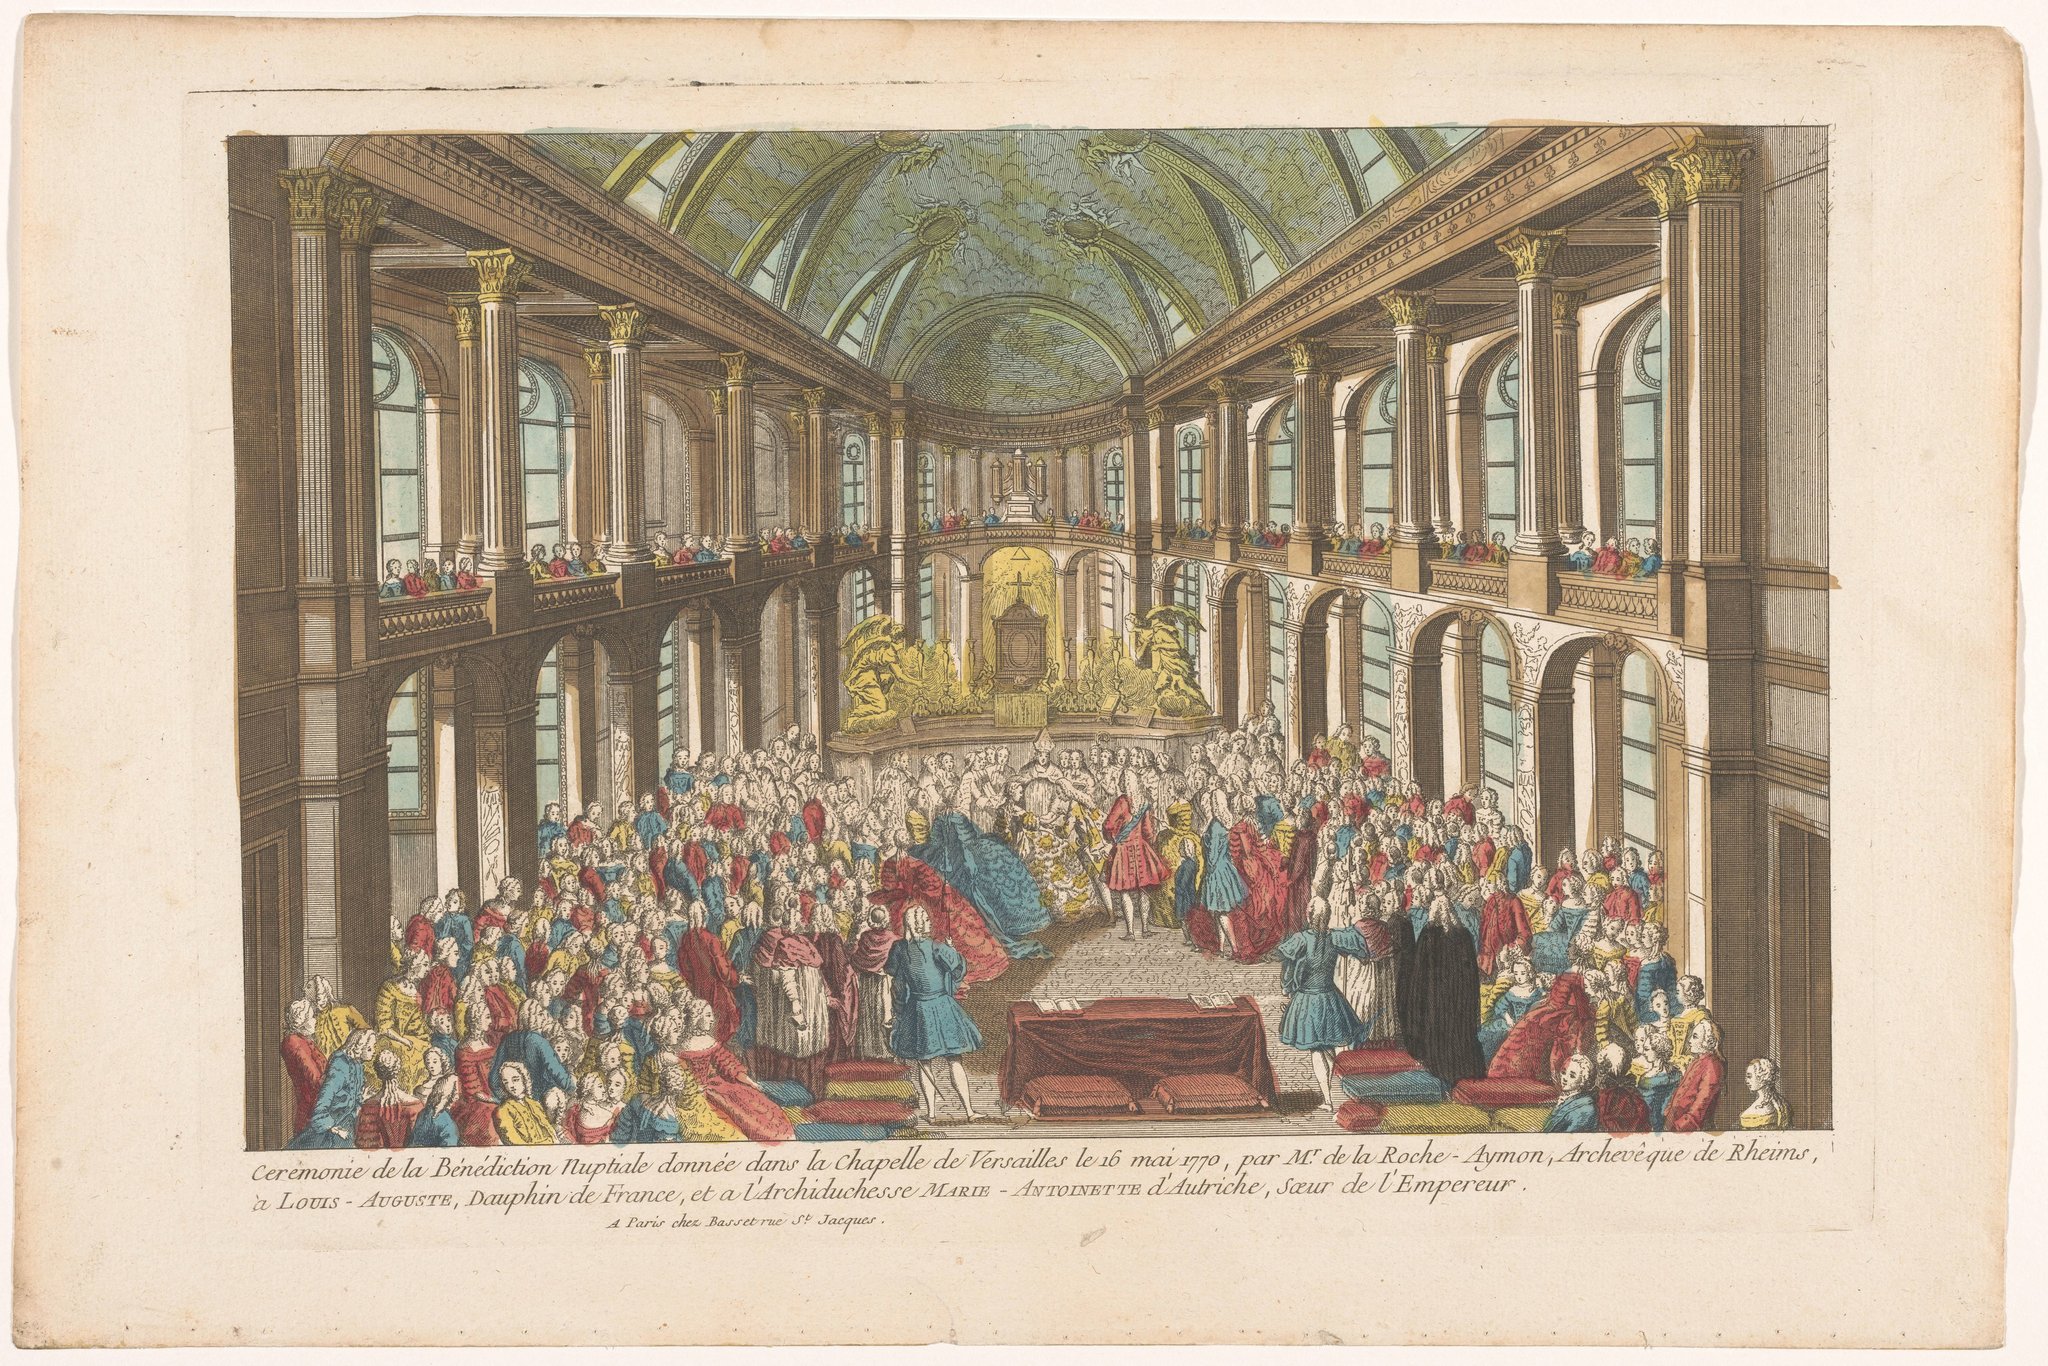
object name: opticaprent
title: Cerémonie de la bénédiction nuptiale donnée dans la chapelle de Versailles le 16 mai 1770 (...)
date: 1700-1799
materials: paper, watercolor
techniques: brush, etching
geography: france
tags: lodewijk xvi (koning van frankrijk), vienna, paris, marie antoinette, (civil) marriage ceremonies, parts of church interior: chapel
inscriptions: collector's mark: Lugt 2166